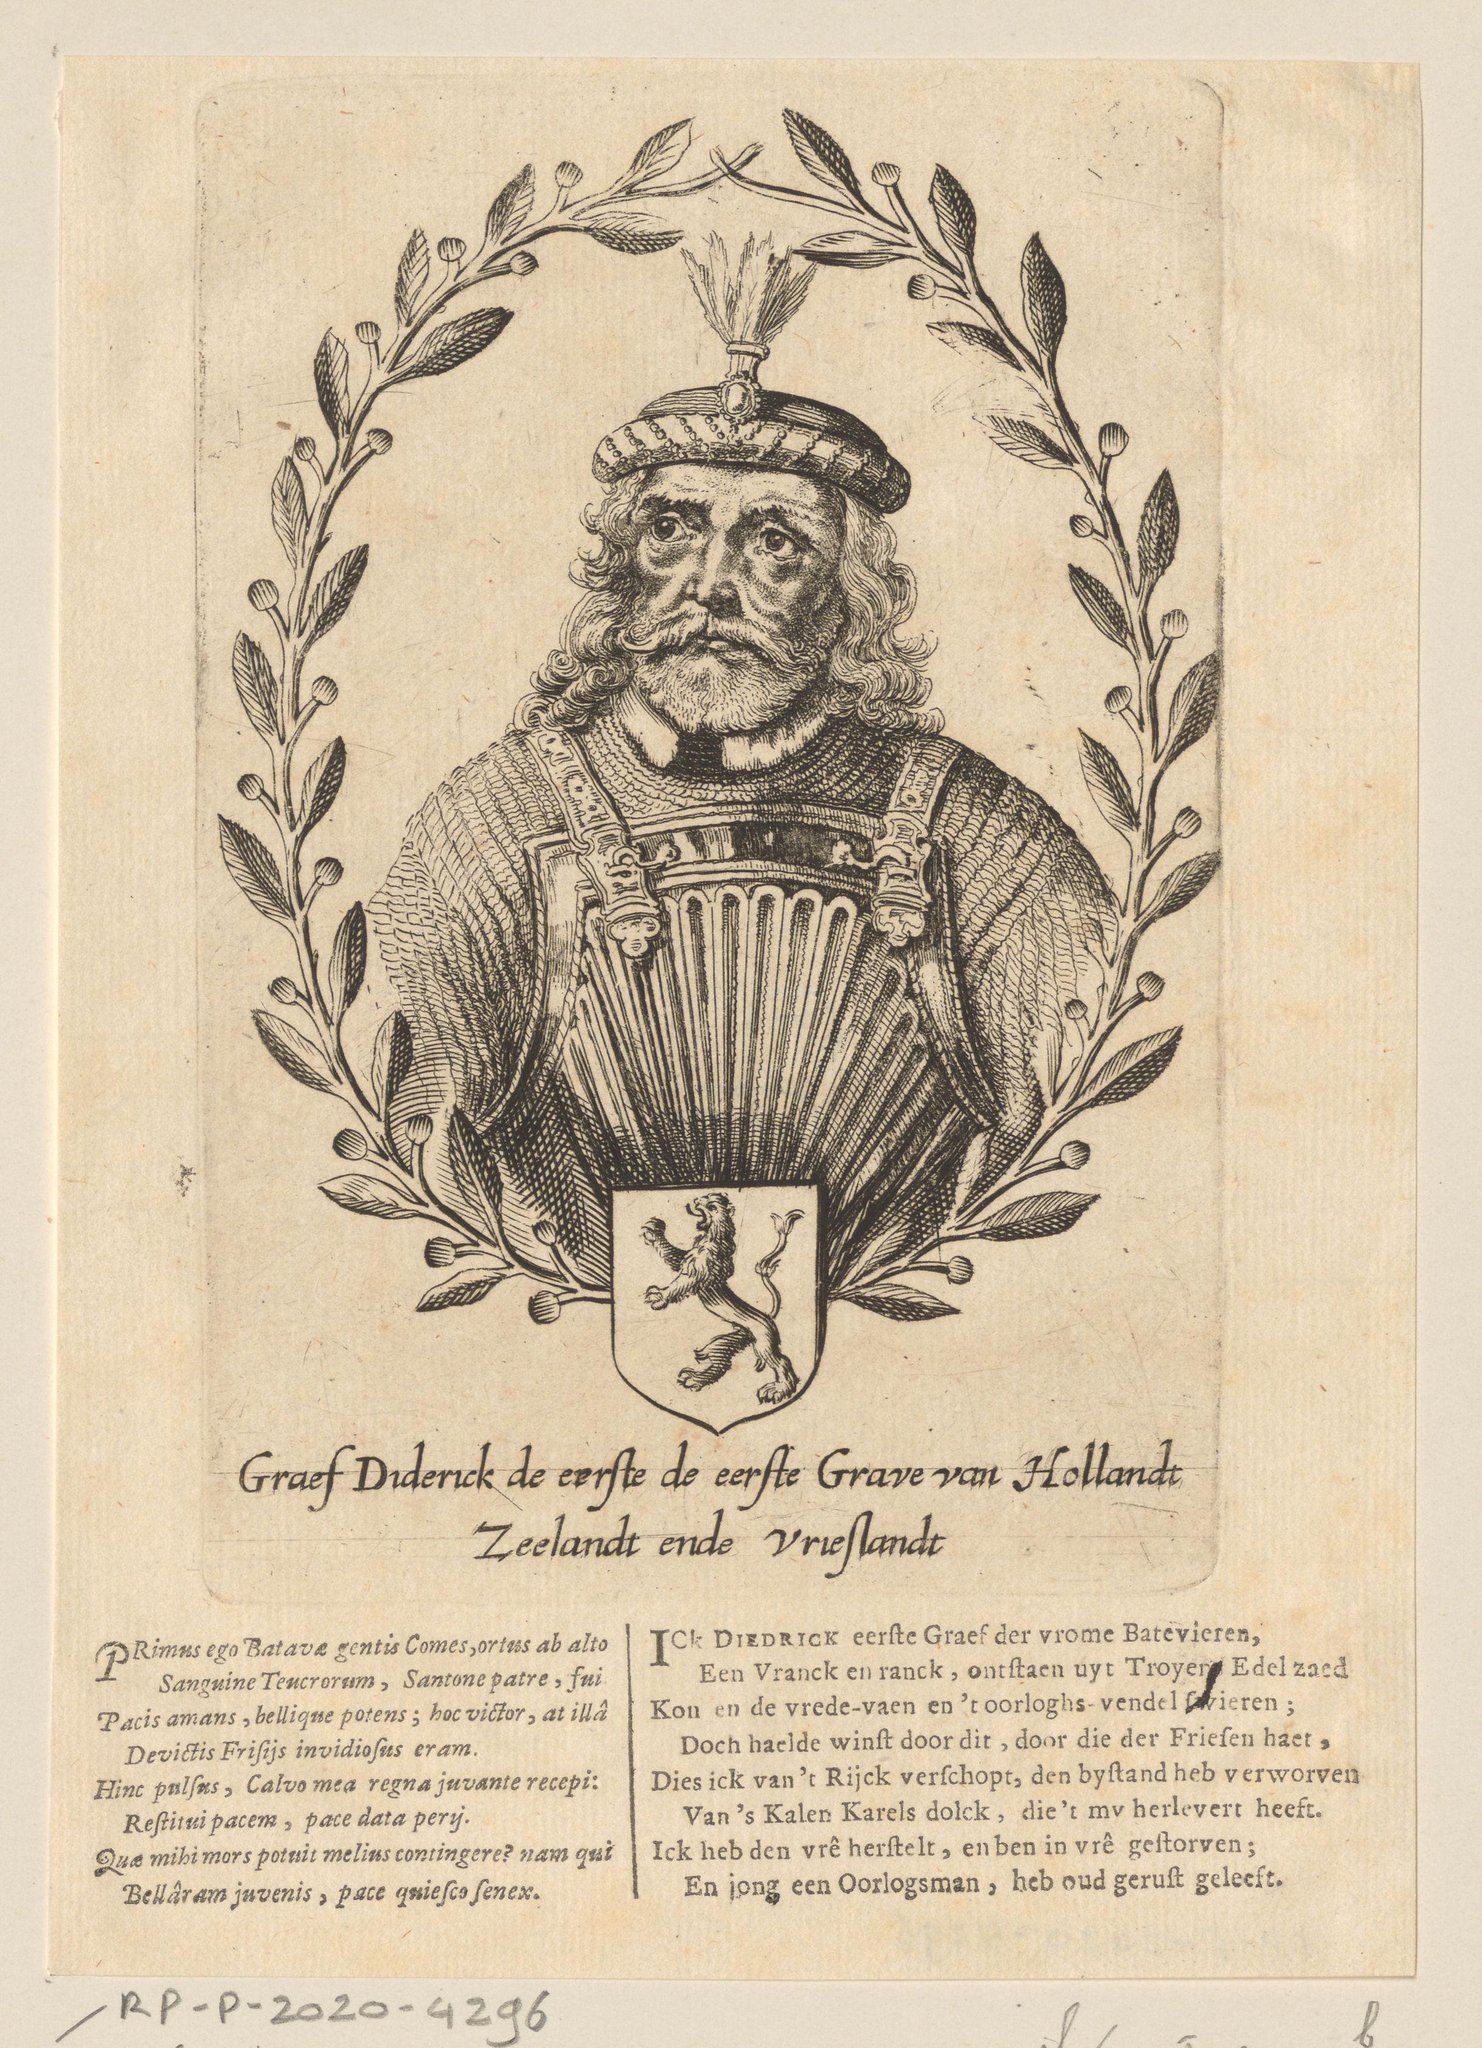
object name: book illustration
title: Portret van Dirk I, graaf van Holland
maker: Anonymous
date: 1667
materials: paper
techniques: engraving, etching, letterpress printing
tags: historical persons, head-gear: hat, ruler, sovereign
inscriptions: collector's mark: Lugt 964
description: Prent mogelijk uit: Scriverius, Petrus. Oude en nieuwe beschryvinge van Holland, Zeeland en Vriesland (...). Den Haag: Levijn van Dijck, 1667. Of uit: Scriverius, Petrus. Hollandsche, Zeelandsche ende Vriesche chronyck. Den Haag: Johannes Tongerloo en Levijn van Dijck, s.a.